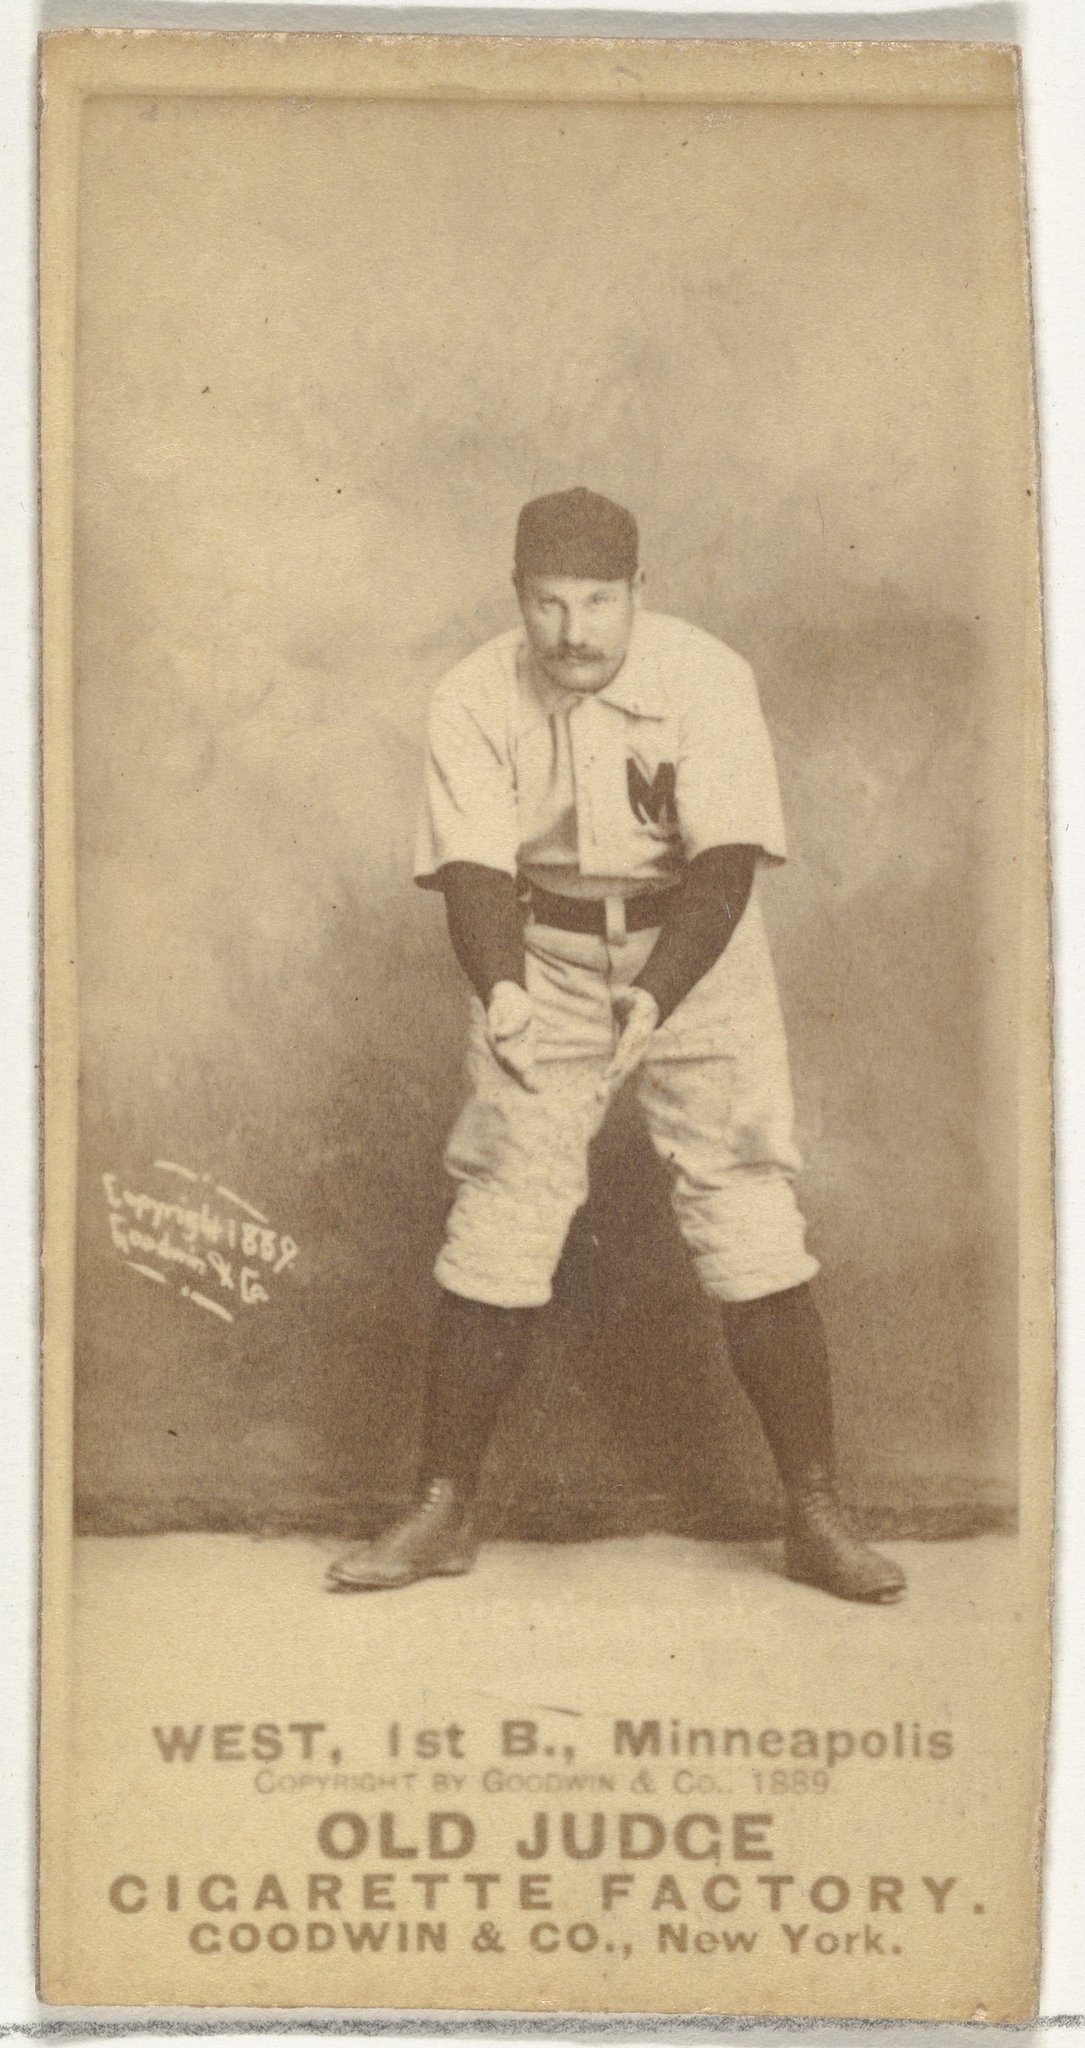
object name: baseball card, photograph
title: Milton Douglas "Buck" West, 1st Base, Minneapolis, from the Old Judge series (N172) for Old Judge Cigarettes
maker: goodwin & company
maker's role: publisher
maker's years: 1850-1950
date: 1889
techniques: albumen silver print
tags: men,portraits,baseball,athletes